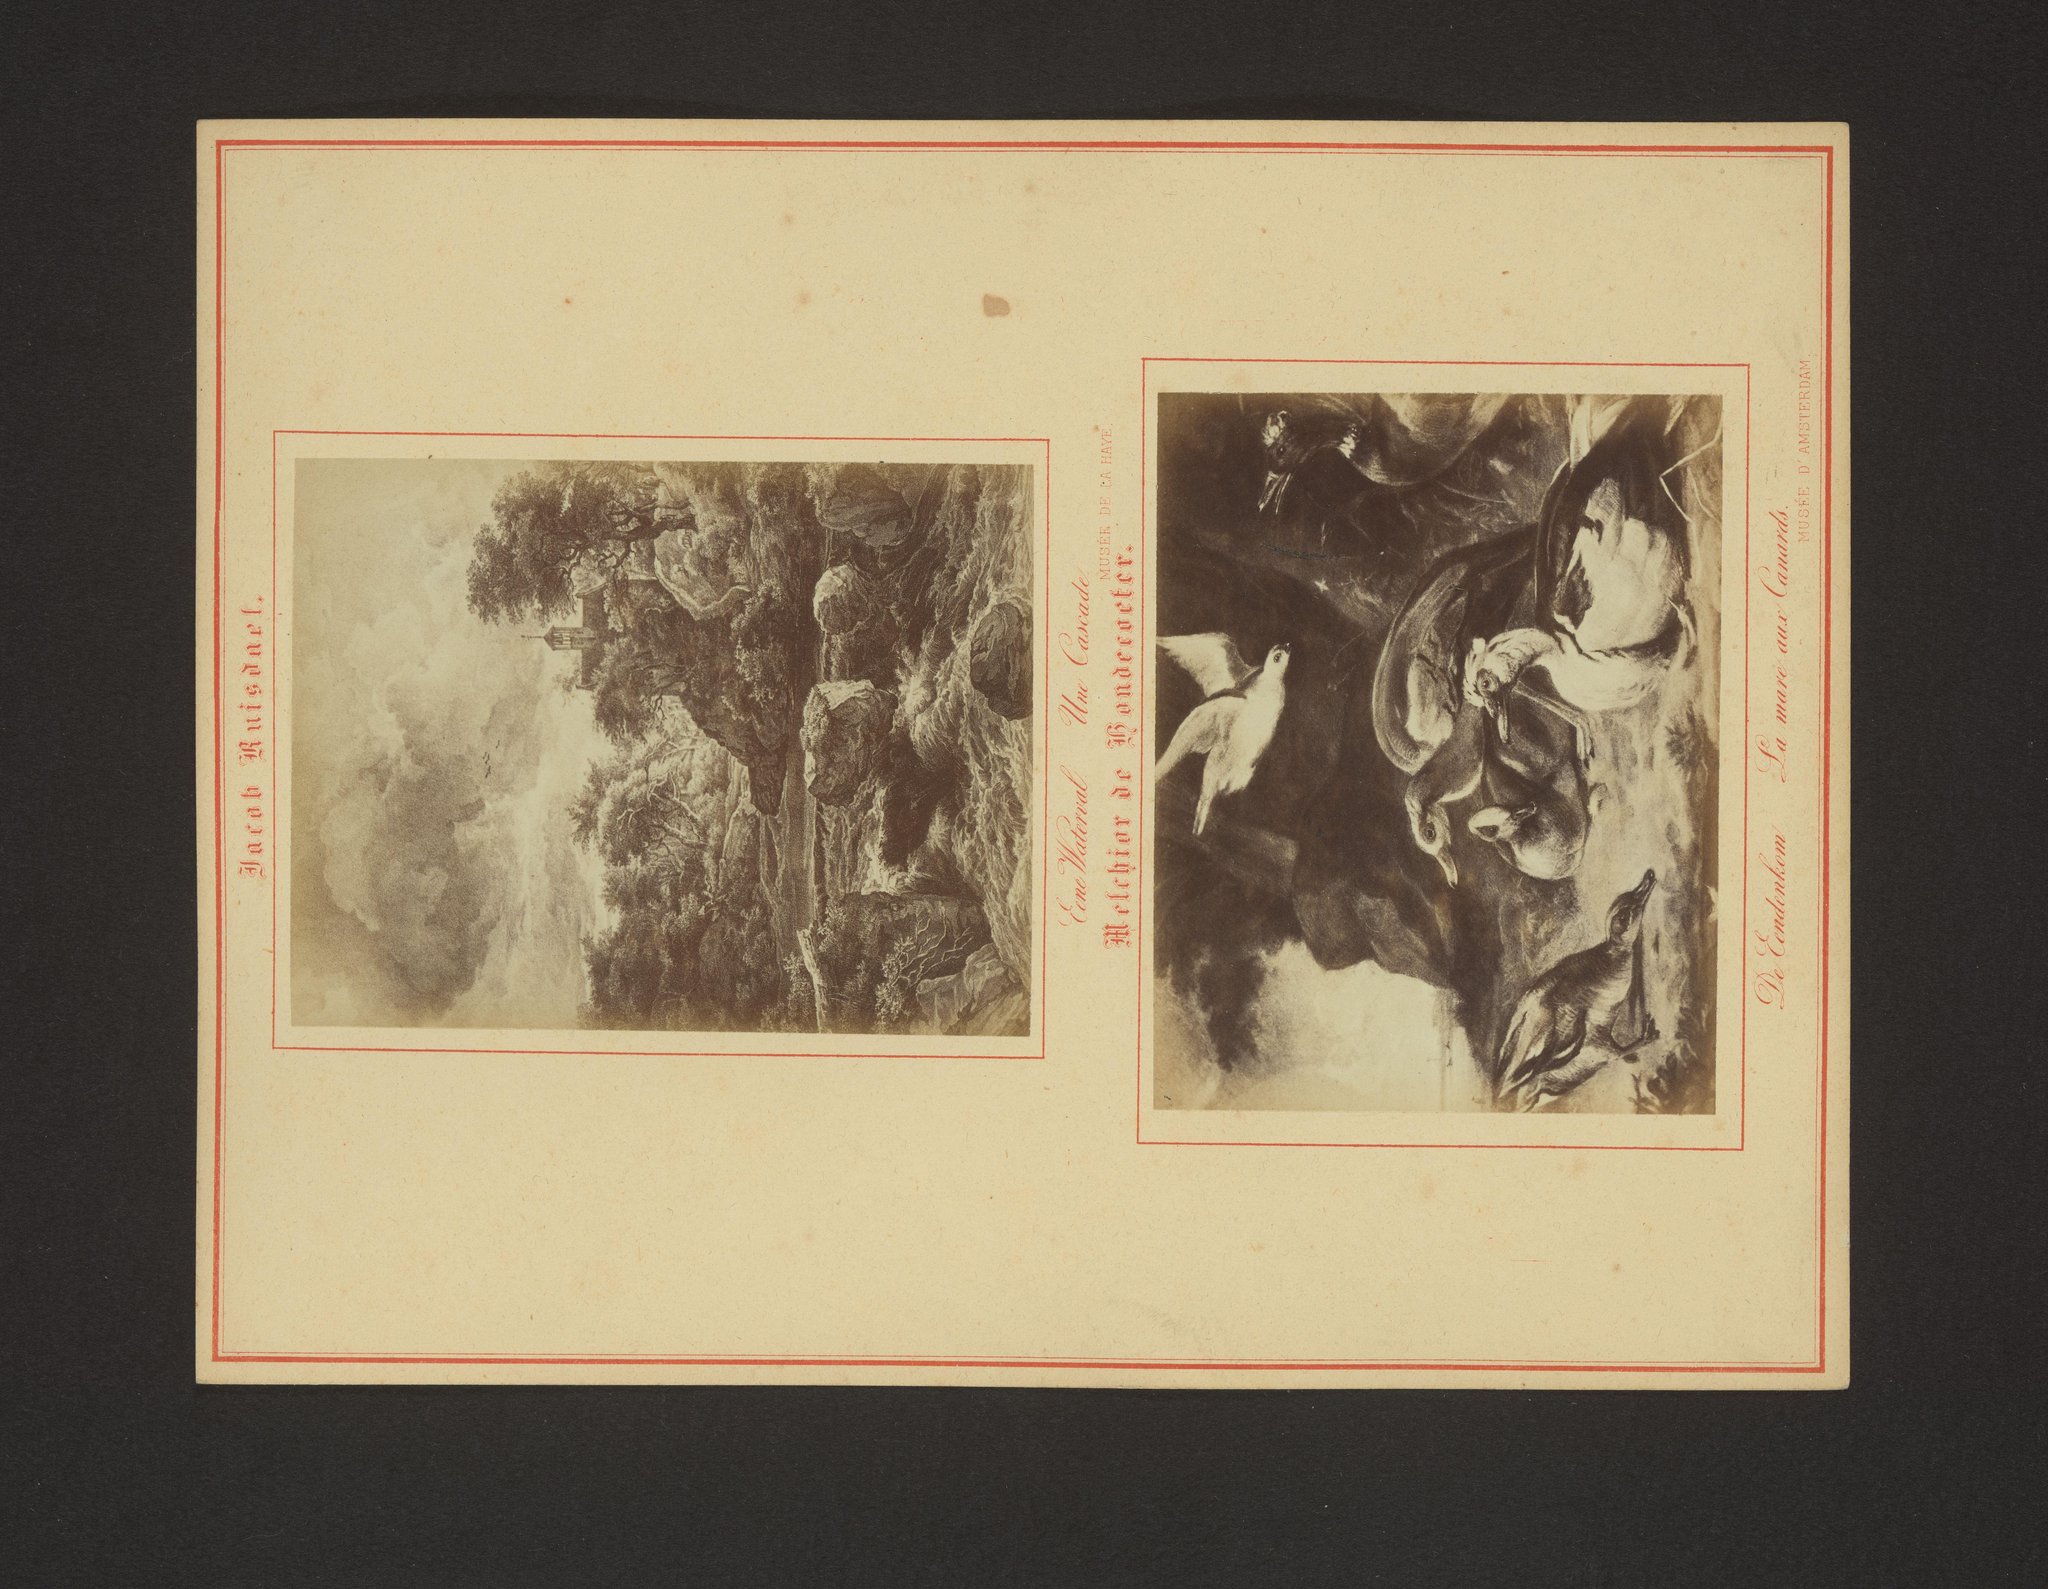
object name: reproduction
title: Fotoreproducties van Waterval met kasteel door Jacob van Ruisdael en Eenden door Melchior d'Hondecoeter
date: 1866-1874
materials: cardboard, photographic support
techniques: albumen print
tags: waterfall, church (exterior), water-birds: duck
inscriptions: annotation: ‘Musée d'Amsterdam’, annotation: ‘Musée de La Haye’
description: Deze foto maakt deel uit van een omslag met 25 foto's.